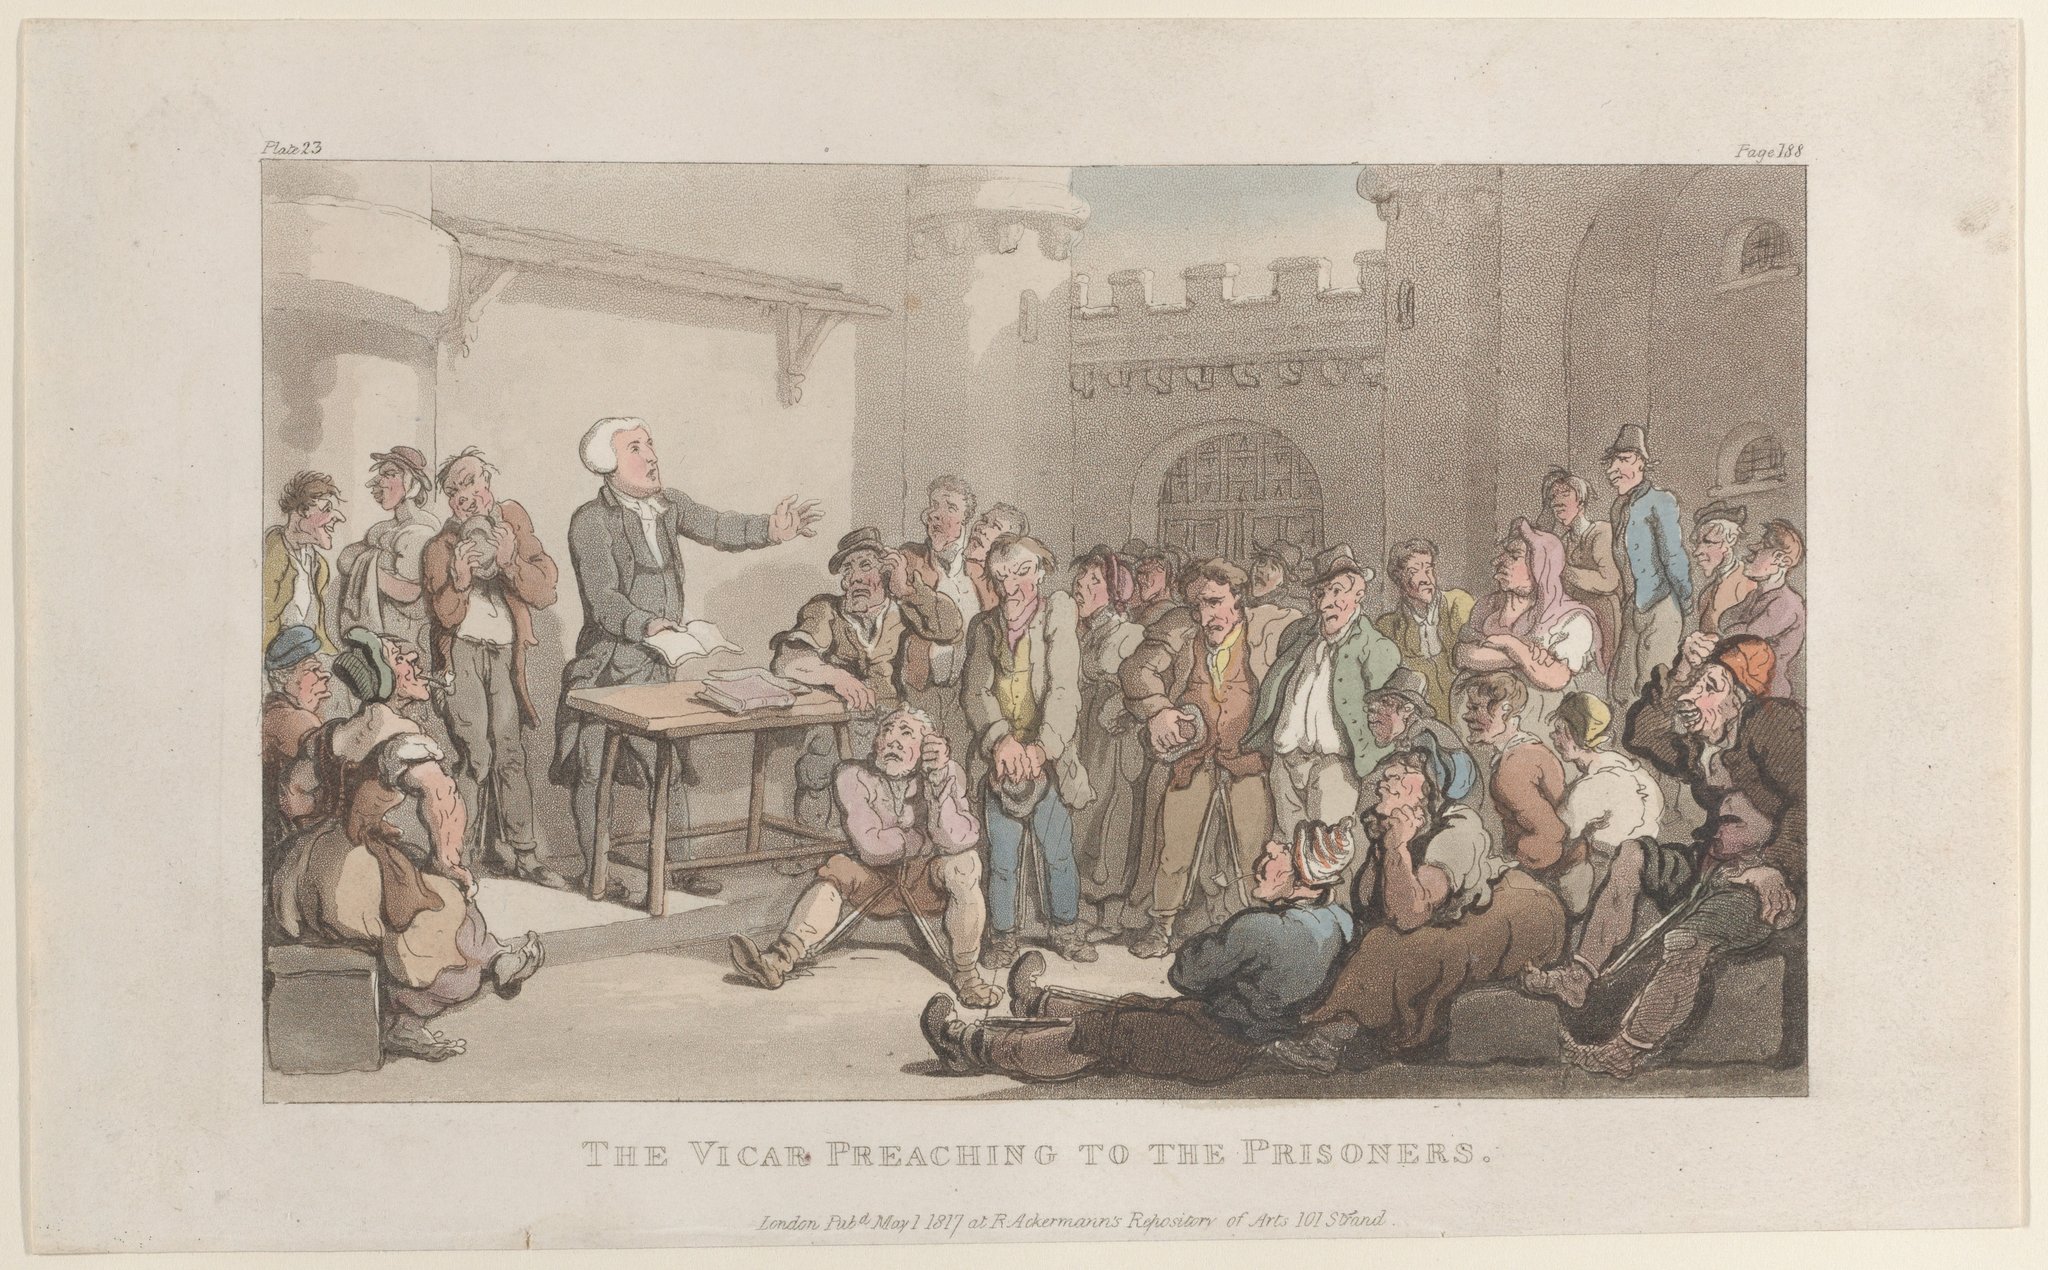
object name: print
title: The Vicar Preaching to the Prisoners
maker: thomas rowlandson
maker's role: artist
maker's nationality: british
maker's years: 1757-1827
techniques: aquatint, etching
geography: london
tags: prisoners,men